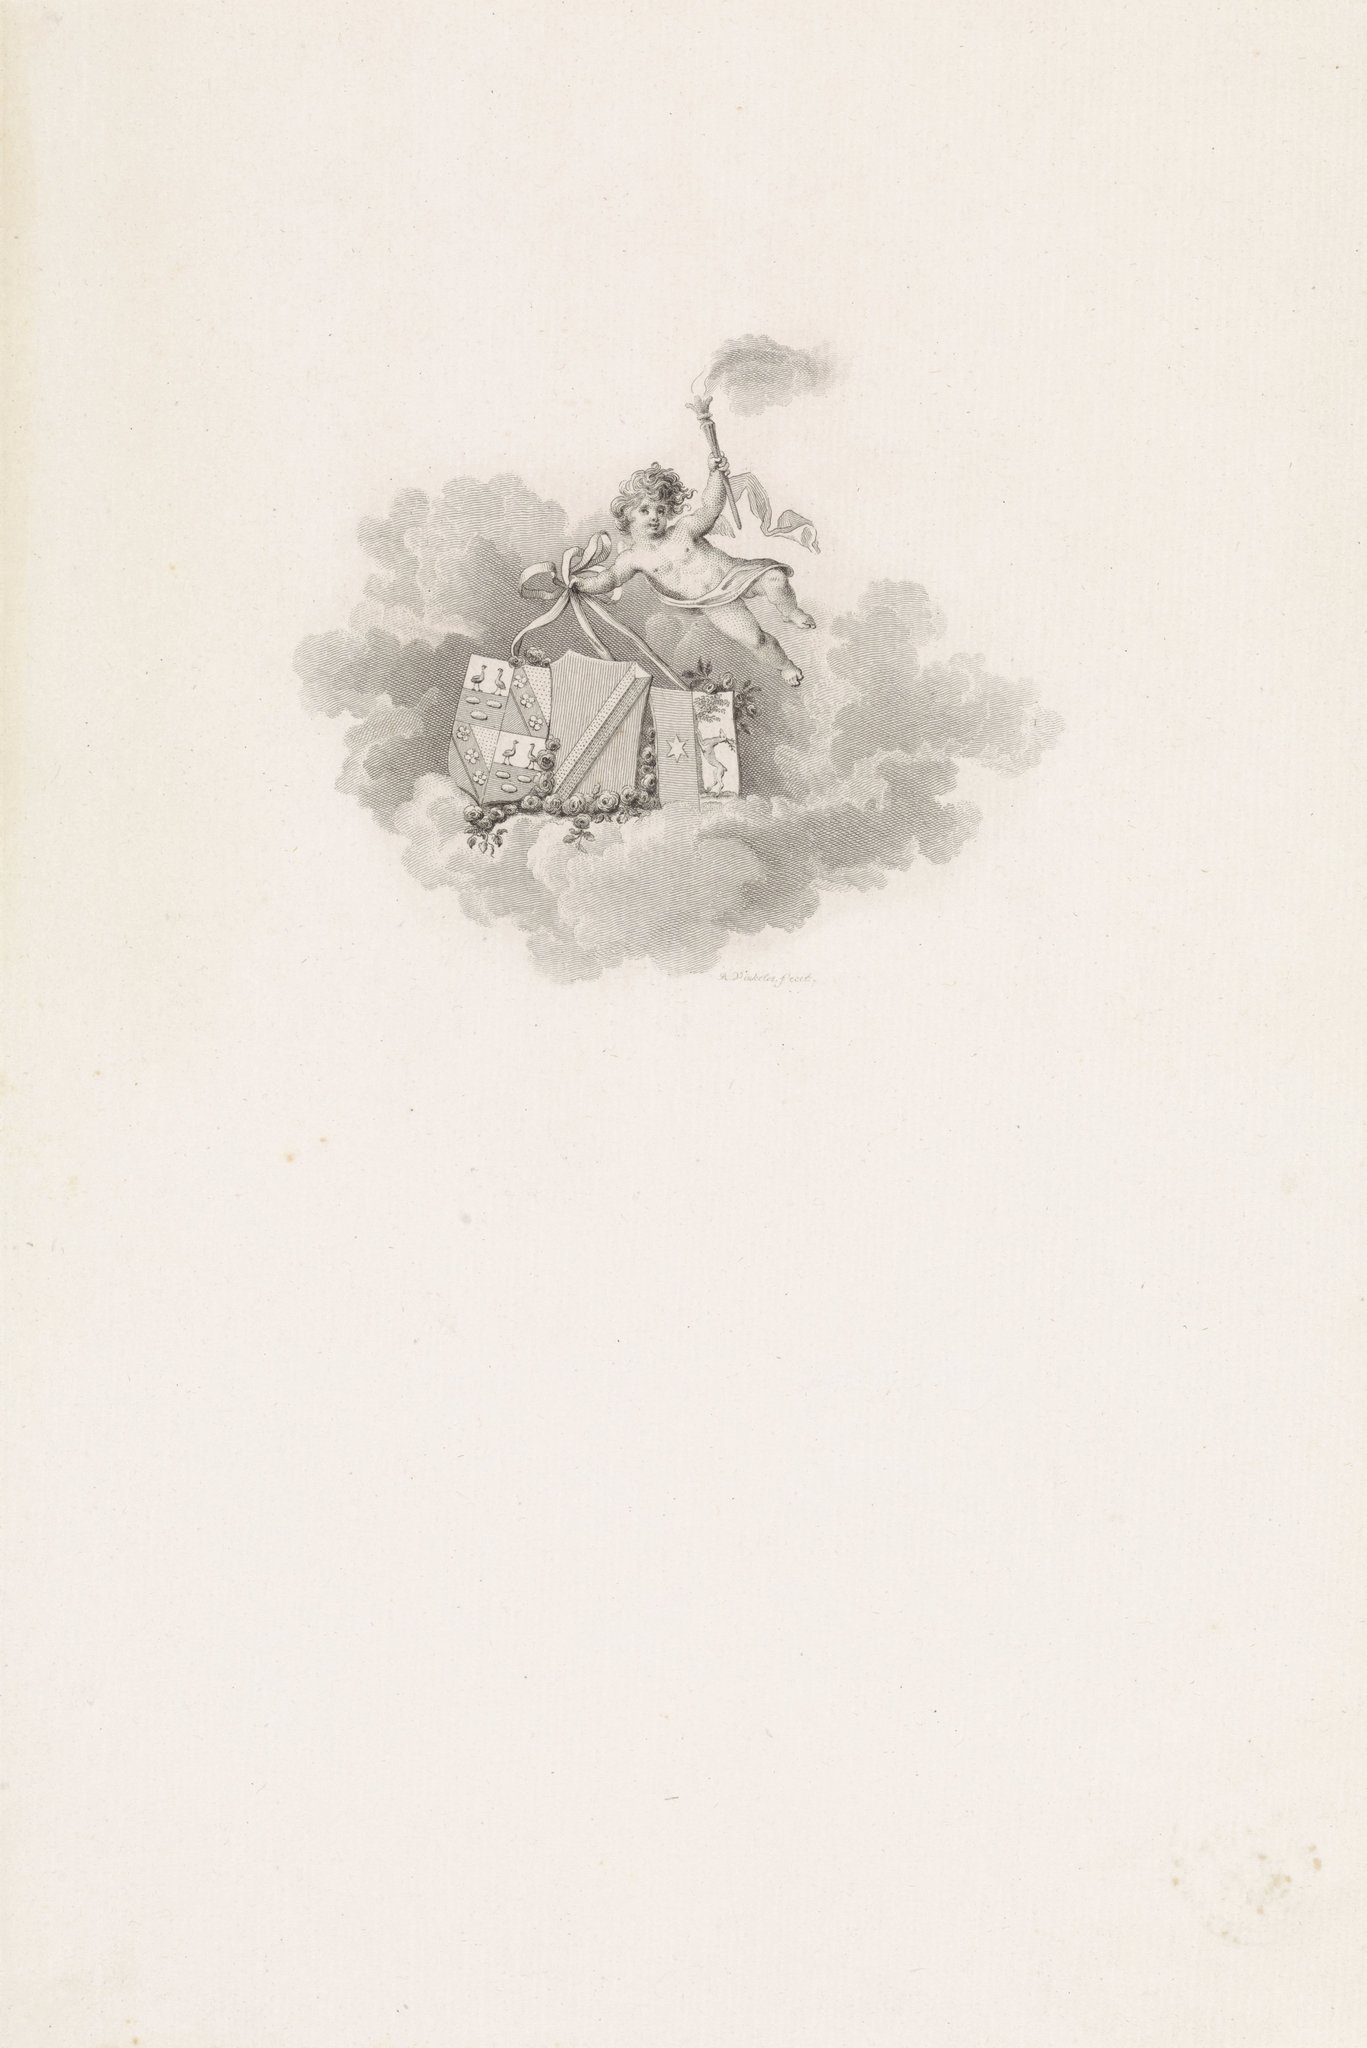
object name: print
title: Putto met drie wapenschilden en een toorts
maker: reinier vinkeles (i)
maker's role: draughtsman, print maker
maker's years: 1741-1816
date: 1751-1816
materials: paper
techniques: engraving, etching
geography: amsterdam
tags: cupids: 'amores', 'amoretti', 'putti', armorial bearing, heraldry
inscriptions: collector's mark: Lugt 240